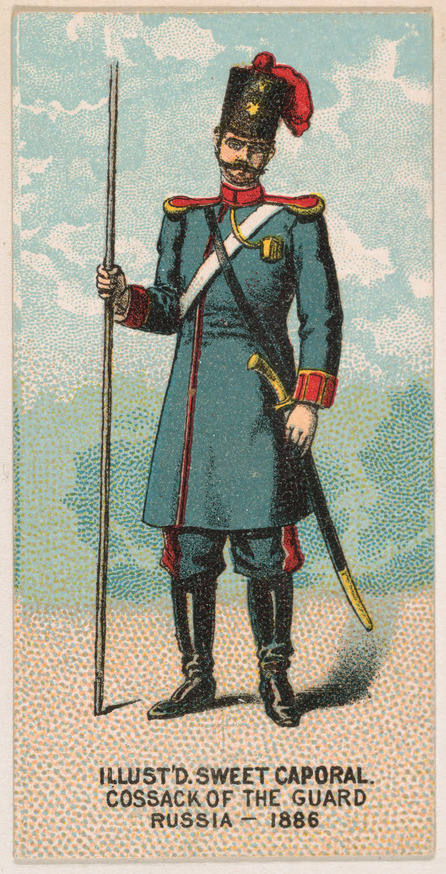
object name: print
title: Cossack of the Guard, Russia, 1886, from the Military Series (N224) issued by Kinney Tobacco Company to promote Sweet Caporal Cigarettes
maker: kinney brothers tobacco company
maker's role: publisher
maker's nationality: american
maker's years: 1869-2011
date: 1888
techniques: color lithograph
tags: military,swords,men